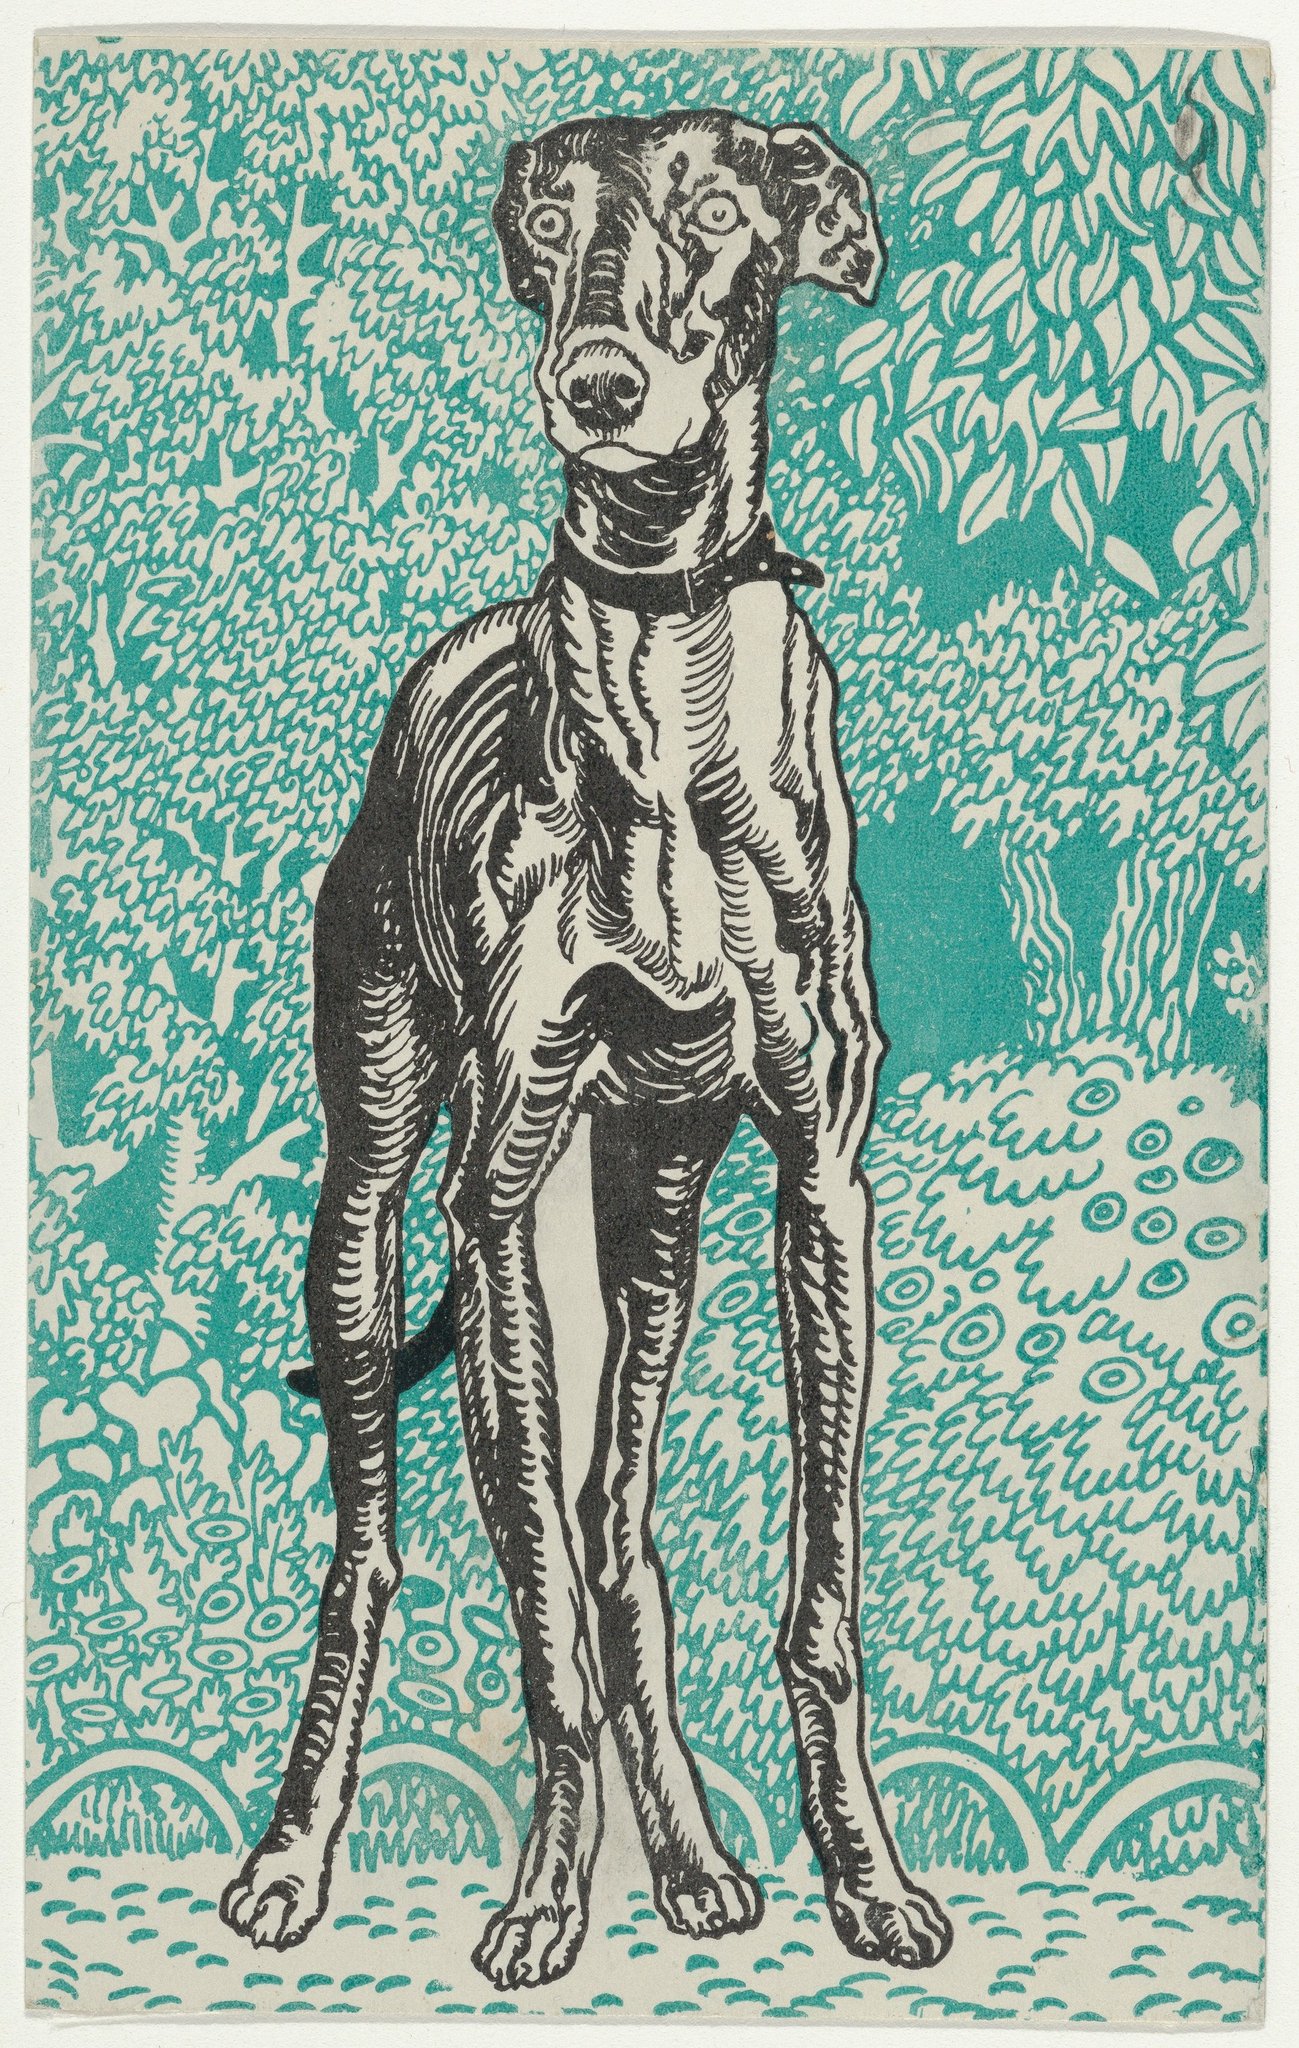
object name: print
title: Greyhound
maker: moriz jung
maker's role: artist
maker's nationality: austrian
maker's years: 1885-1915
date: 1912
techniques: lithograph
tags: dogs